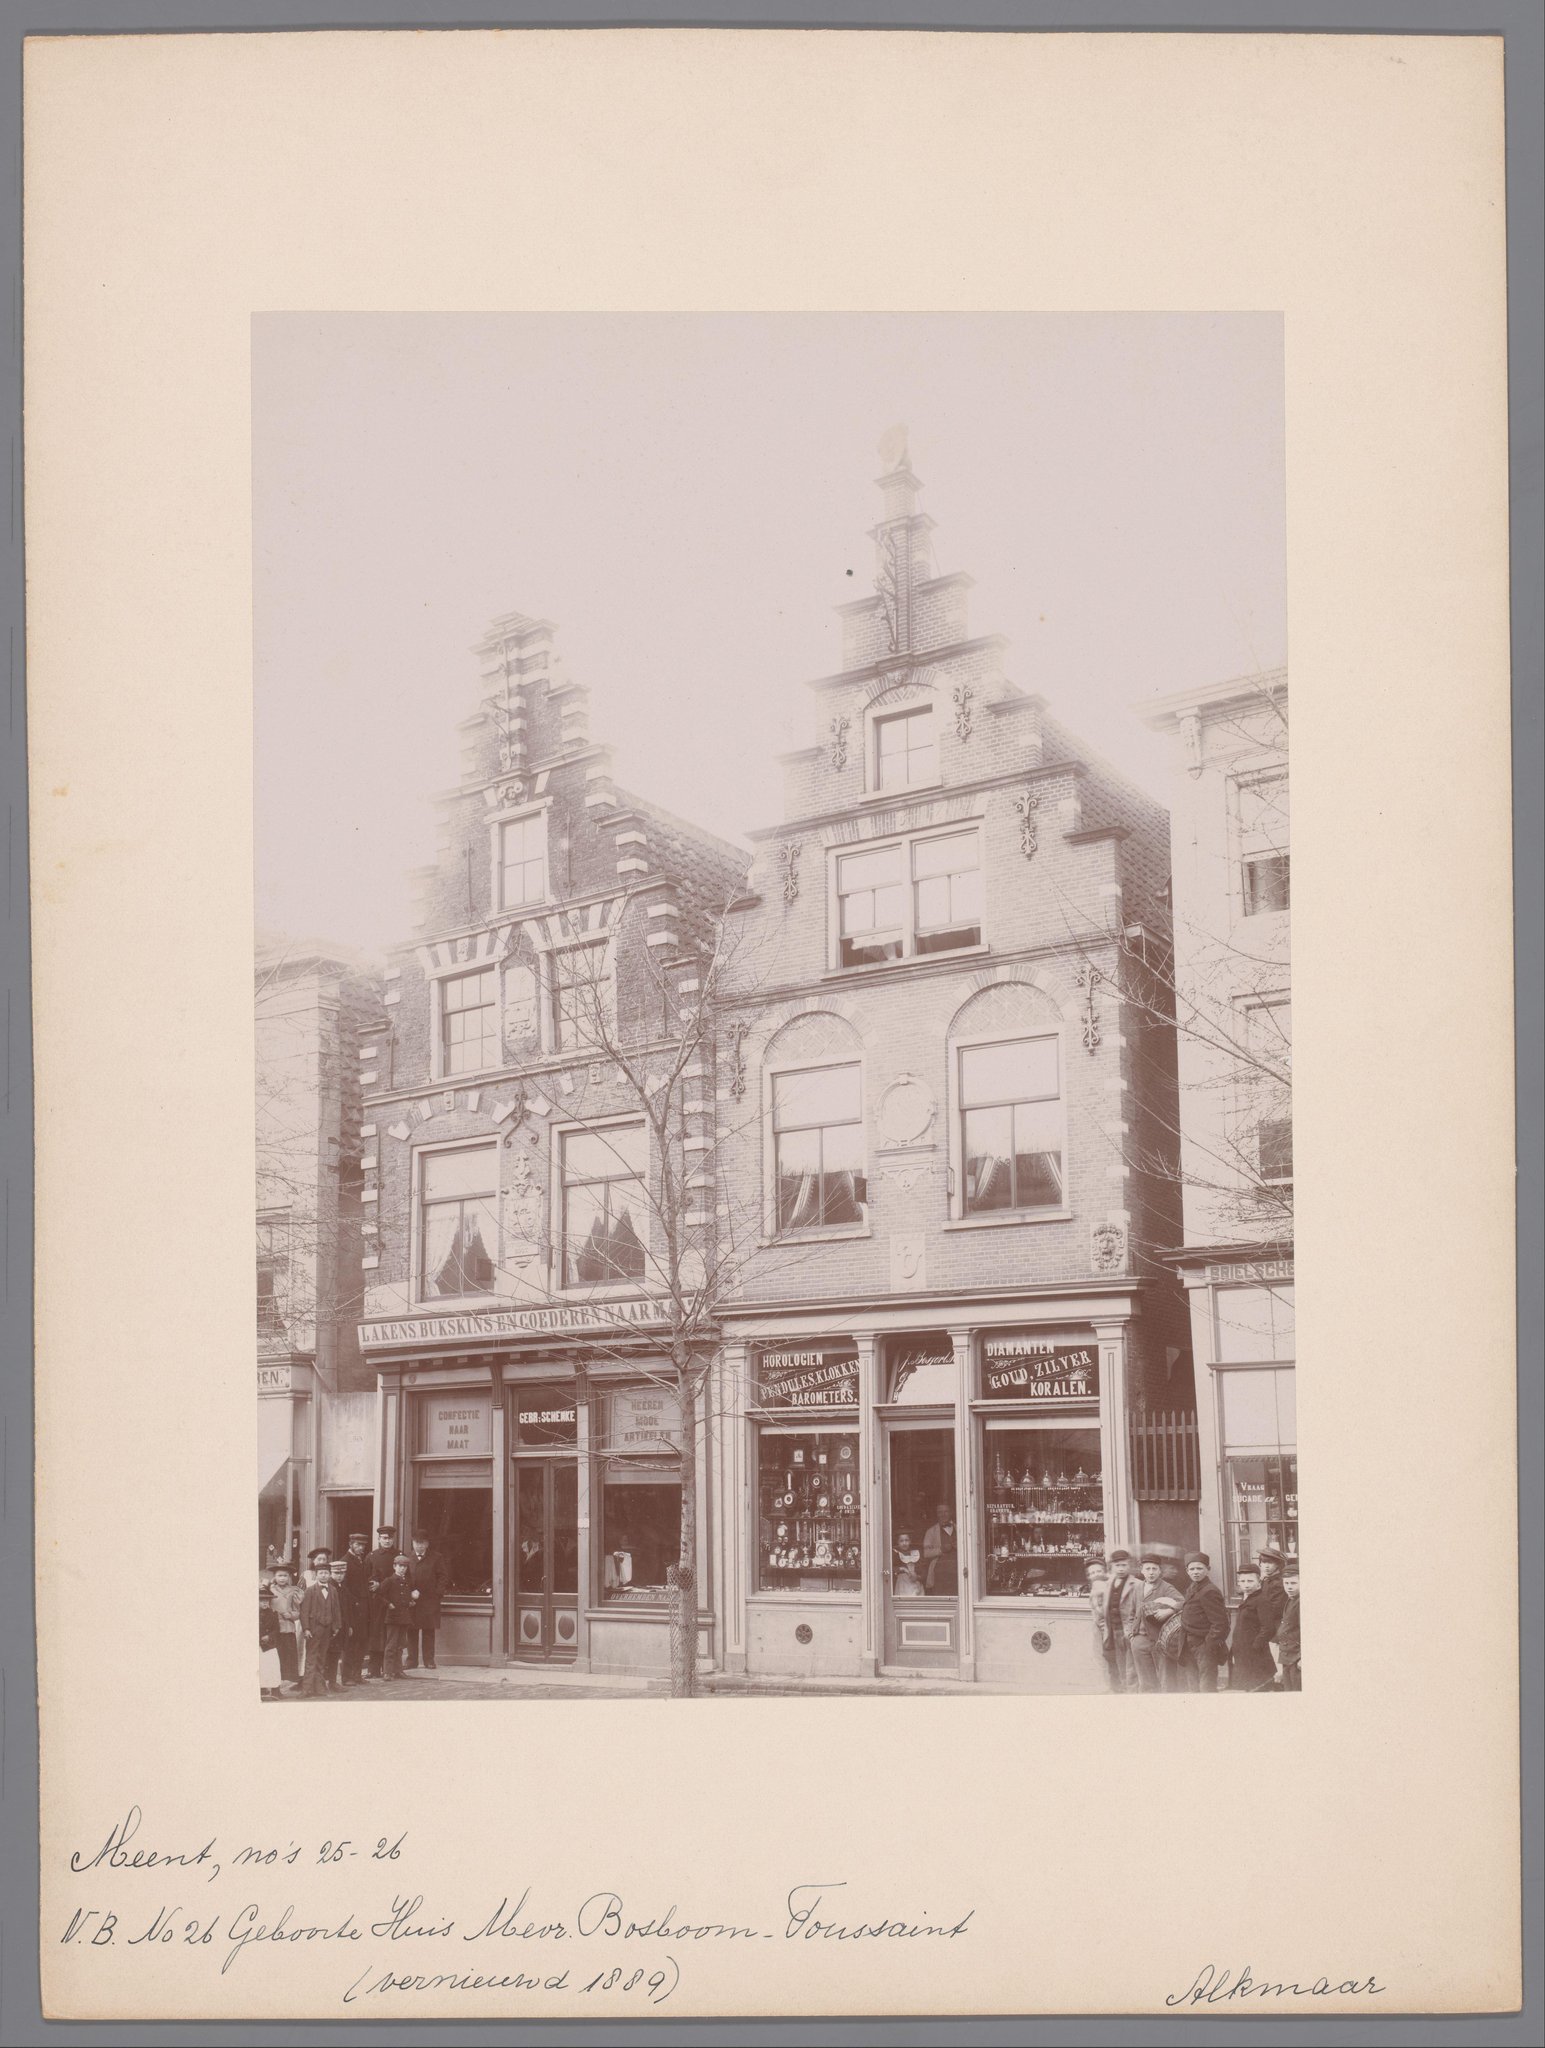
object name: photograph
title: Geboortehuis van A.G. Bosboom-Toussaint op Meent 25-26 te Alkmaar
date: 1889-1900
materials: cardboard, photographic support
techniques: gelatin silver print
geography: meent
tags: the hague, anna louisa geertruyda bosboom-toussaint, urban housing, façade (of house or building)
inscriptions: annotation: ‘Meent, no's 25-26/ N.B. No 26 Geboorte Huis Mevr. Bosboom-Toussaint/ (vernieuwd 1889)/ Alkmaar’, annotation: ‘Alkmaar (N.H.)/ Huizen No. 25-26 op de Meent/ N.B. No. 26 geboortehuis Mevr. Bosboom Toussaint (huis vernieuwd 1889)’